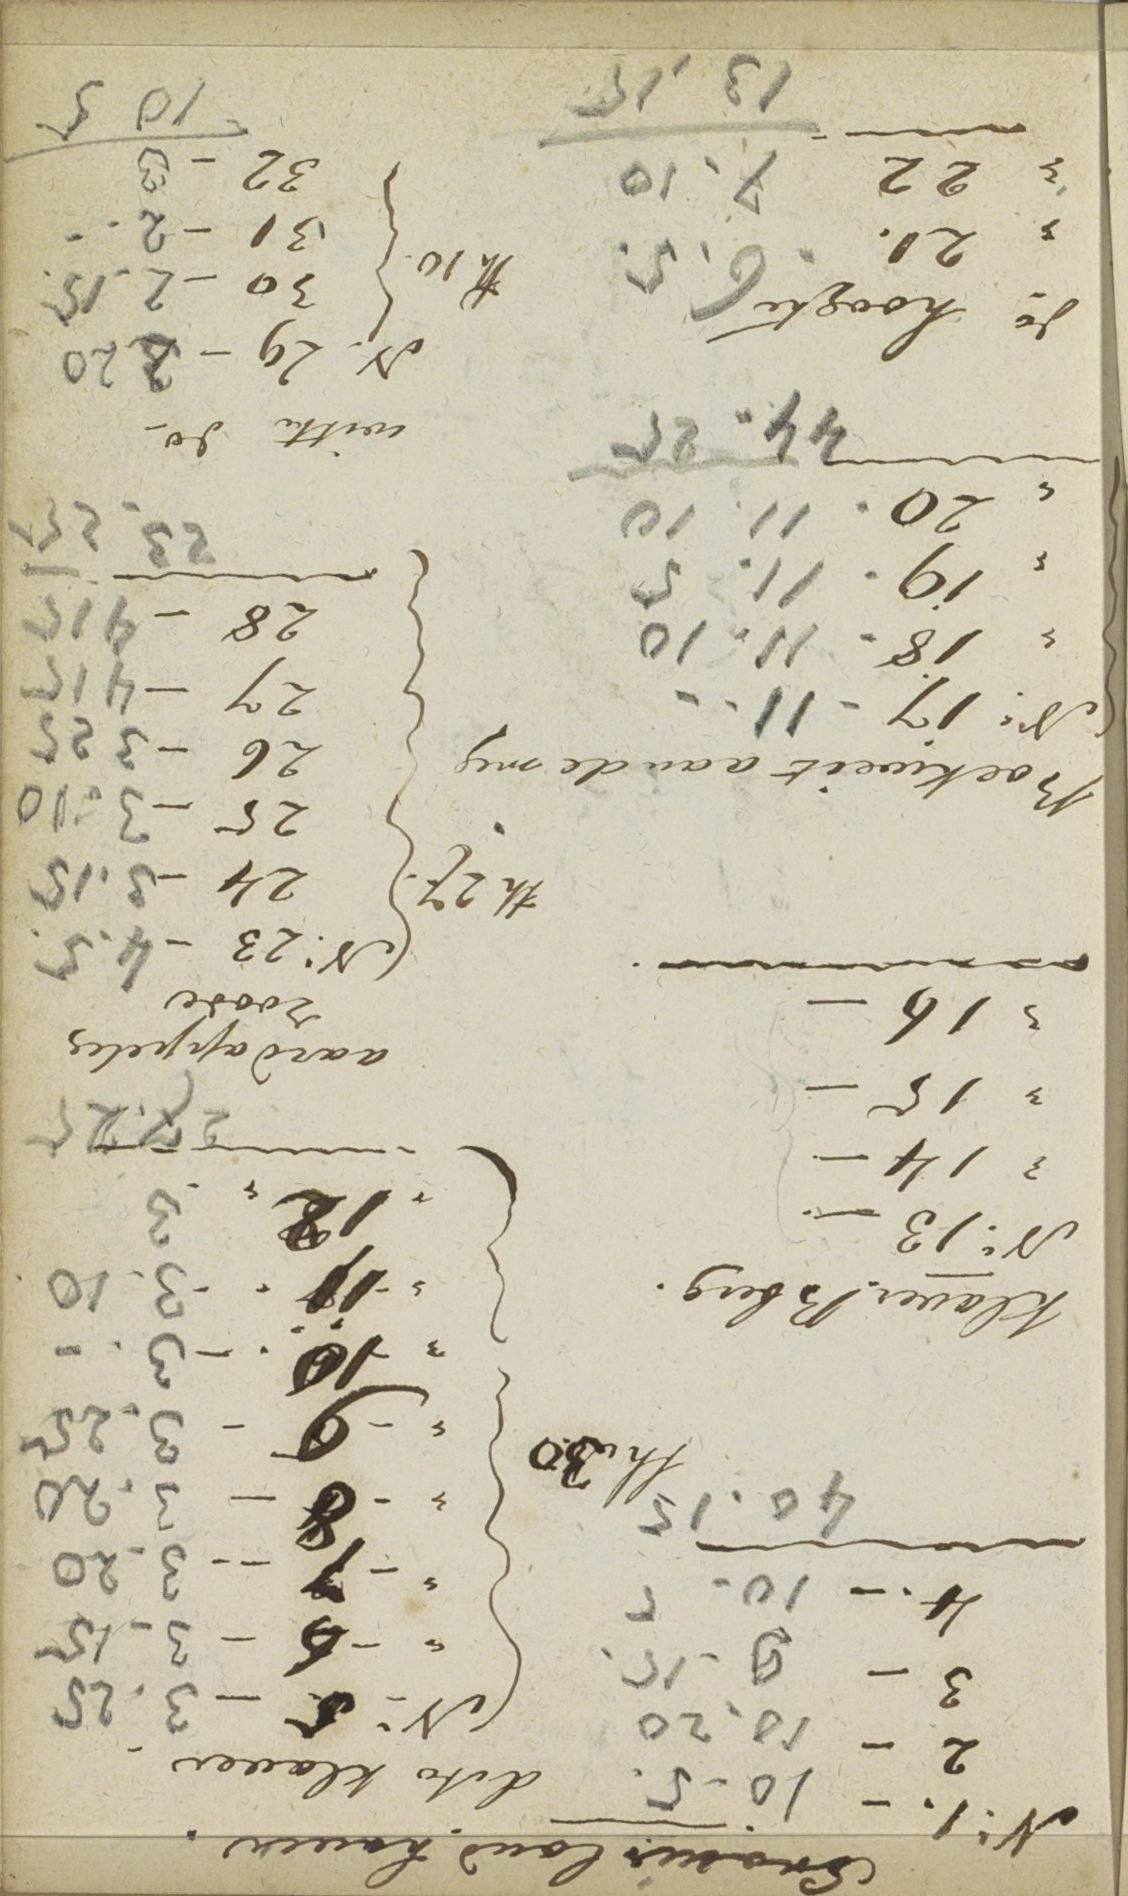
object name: sketchbook leaf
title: Notities over landbouw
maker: johannes tavenraat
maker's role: draughtsman, painter, print maker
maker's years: 1809-1881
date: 1854-1868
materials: ink, paper, pencil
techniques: pen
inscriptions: annotation: ‘[...]’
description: Blad 80 verso uit een schetsboek met 88 bladen.